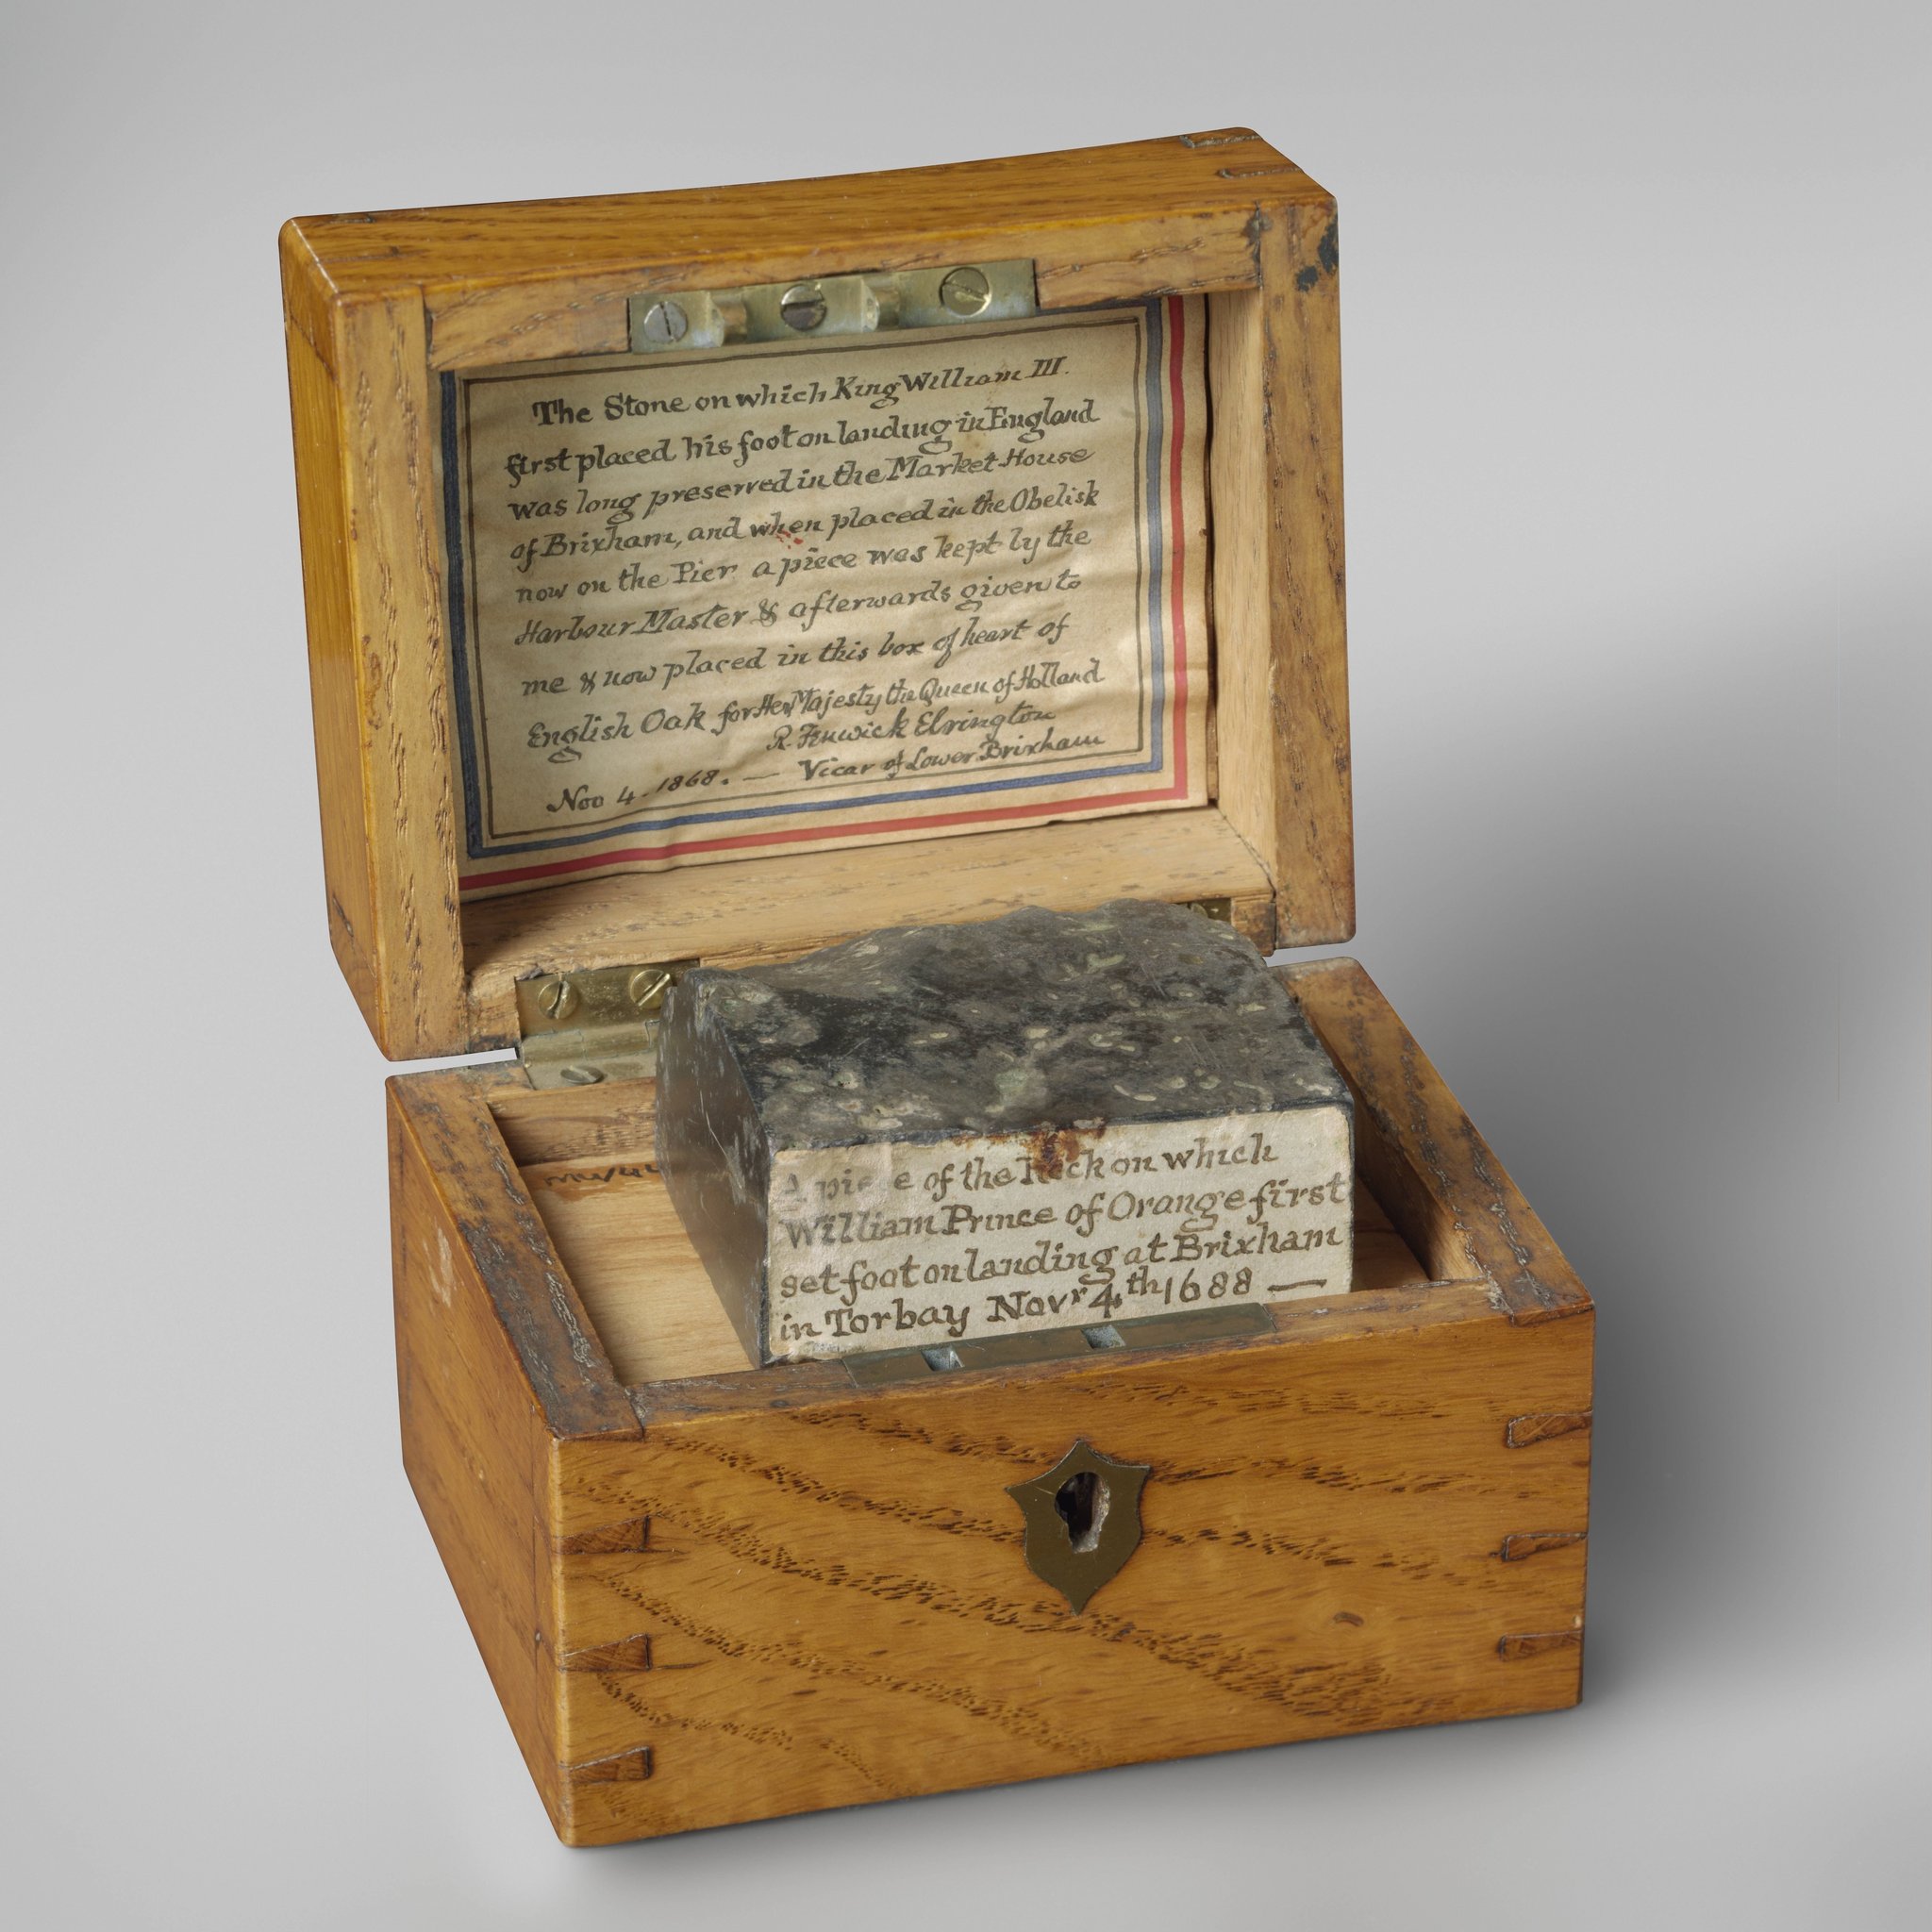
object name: fragment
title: Piece of the stone on which Prince William III set foot on arriving in England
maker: Anonymous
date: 1689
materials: metal, wood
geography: brixham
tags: the hague, william iii (prince of orange and king of england, scotland, and ireland)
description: This is the stone on which William III first stepped when he landed in the fishing village of Brixham in England on 15 November 1688. He invaded England to overthrow his Catholic father-in-law, King James II, and to prevent him – together with the French king Louis XIV – from turning against the Netherlands. Known as the Glorious Revolution, William’s coup was a great success.